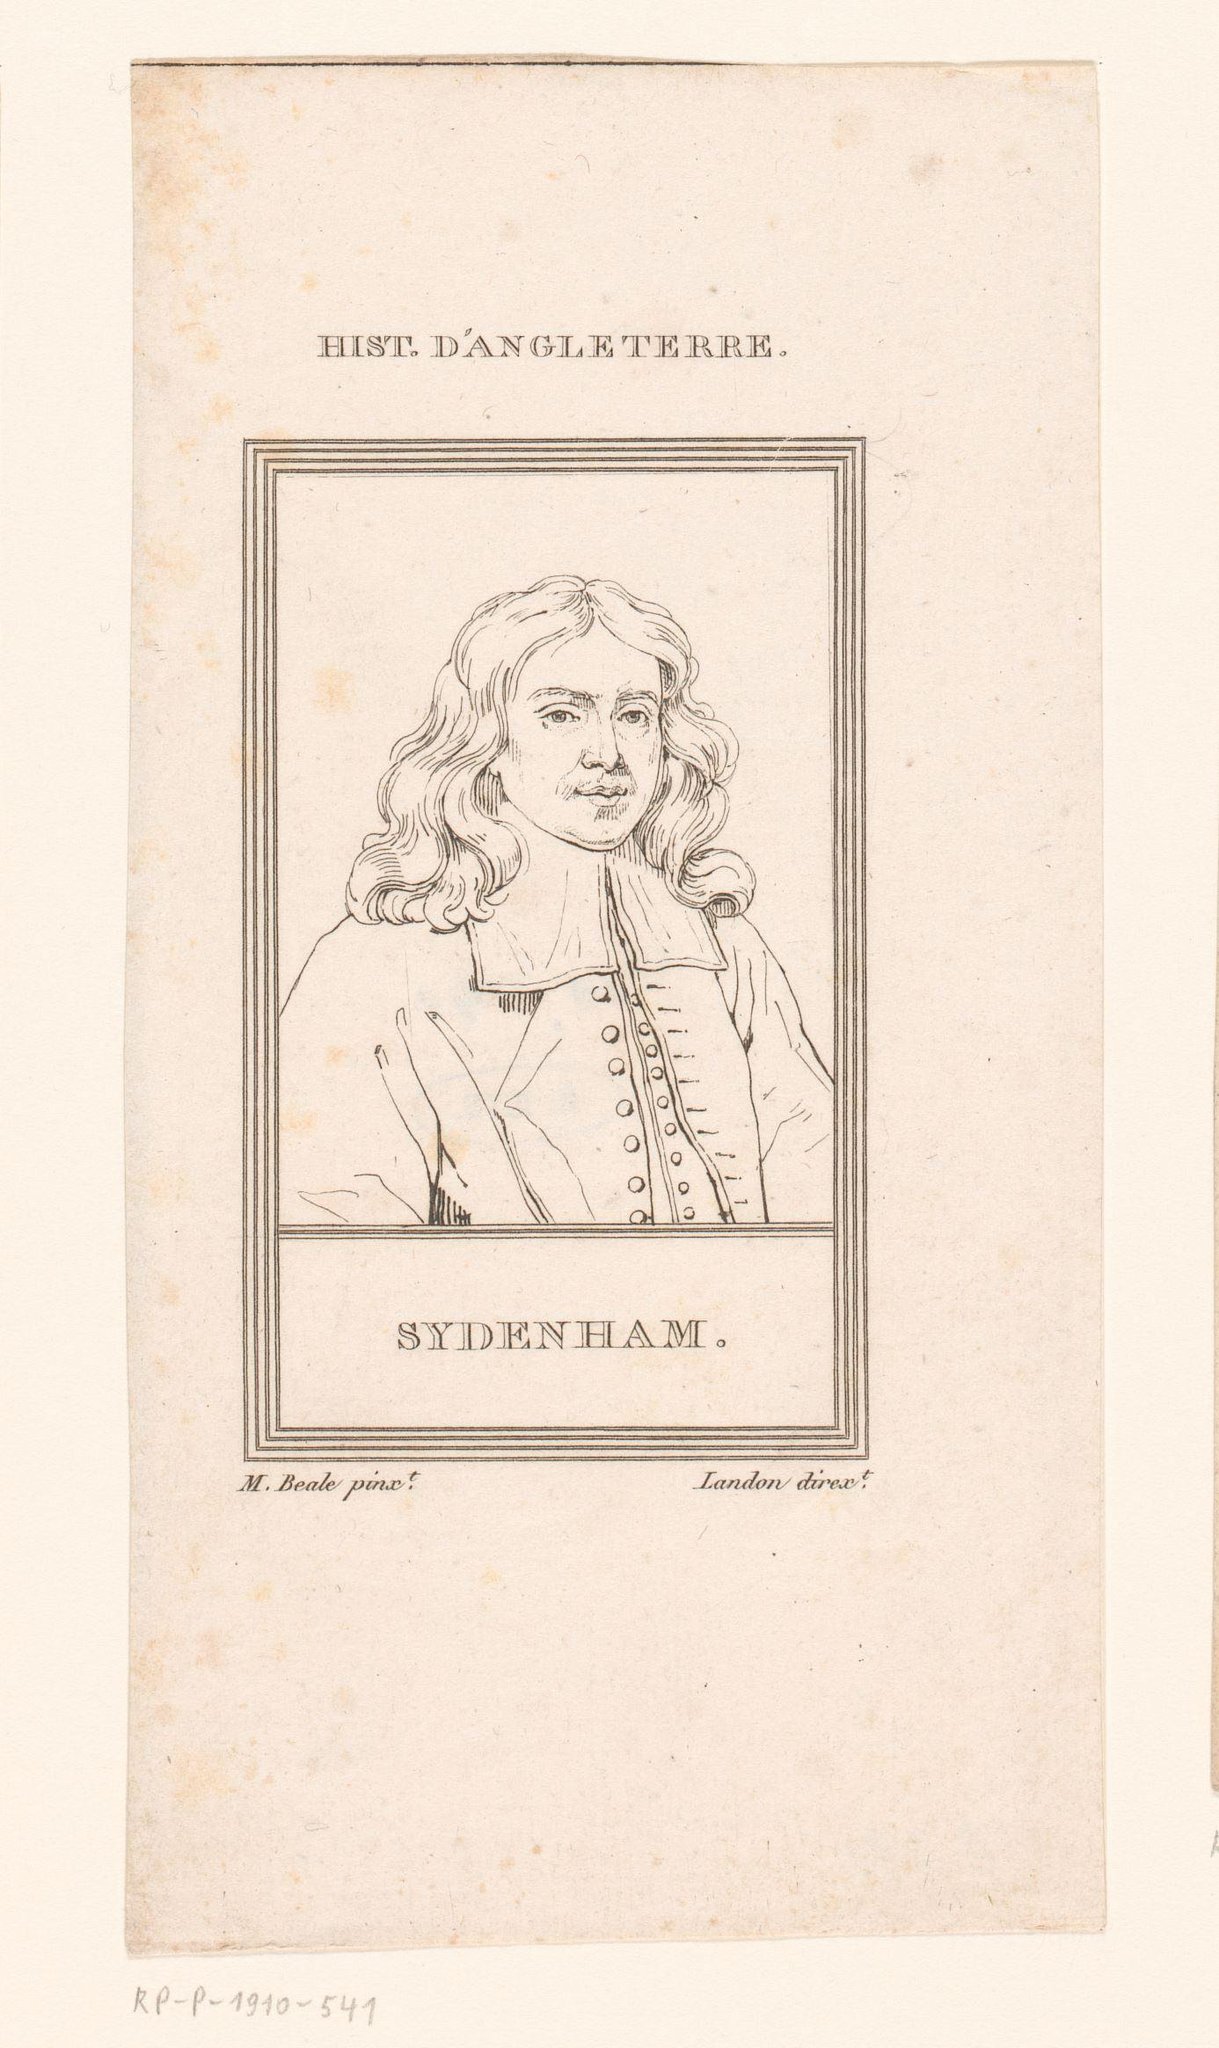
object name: book illustration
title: Portret van Thomas Sydenham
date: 1805-1811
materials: paper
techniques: etching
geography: france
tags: historical persons, physician, doctor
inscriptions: collector's mark: Lugt 2228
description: Prent uit: Landon, Charles Paul. Galerie historique des hommes les plus celebres de tous les nations. (...). Parijs: Musée et l'école des beaux-arts, 1805-1811.